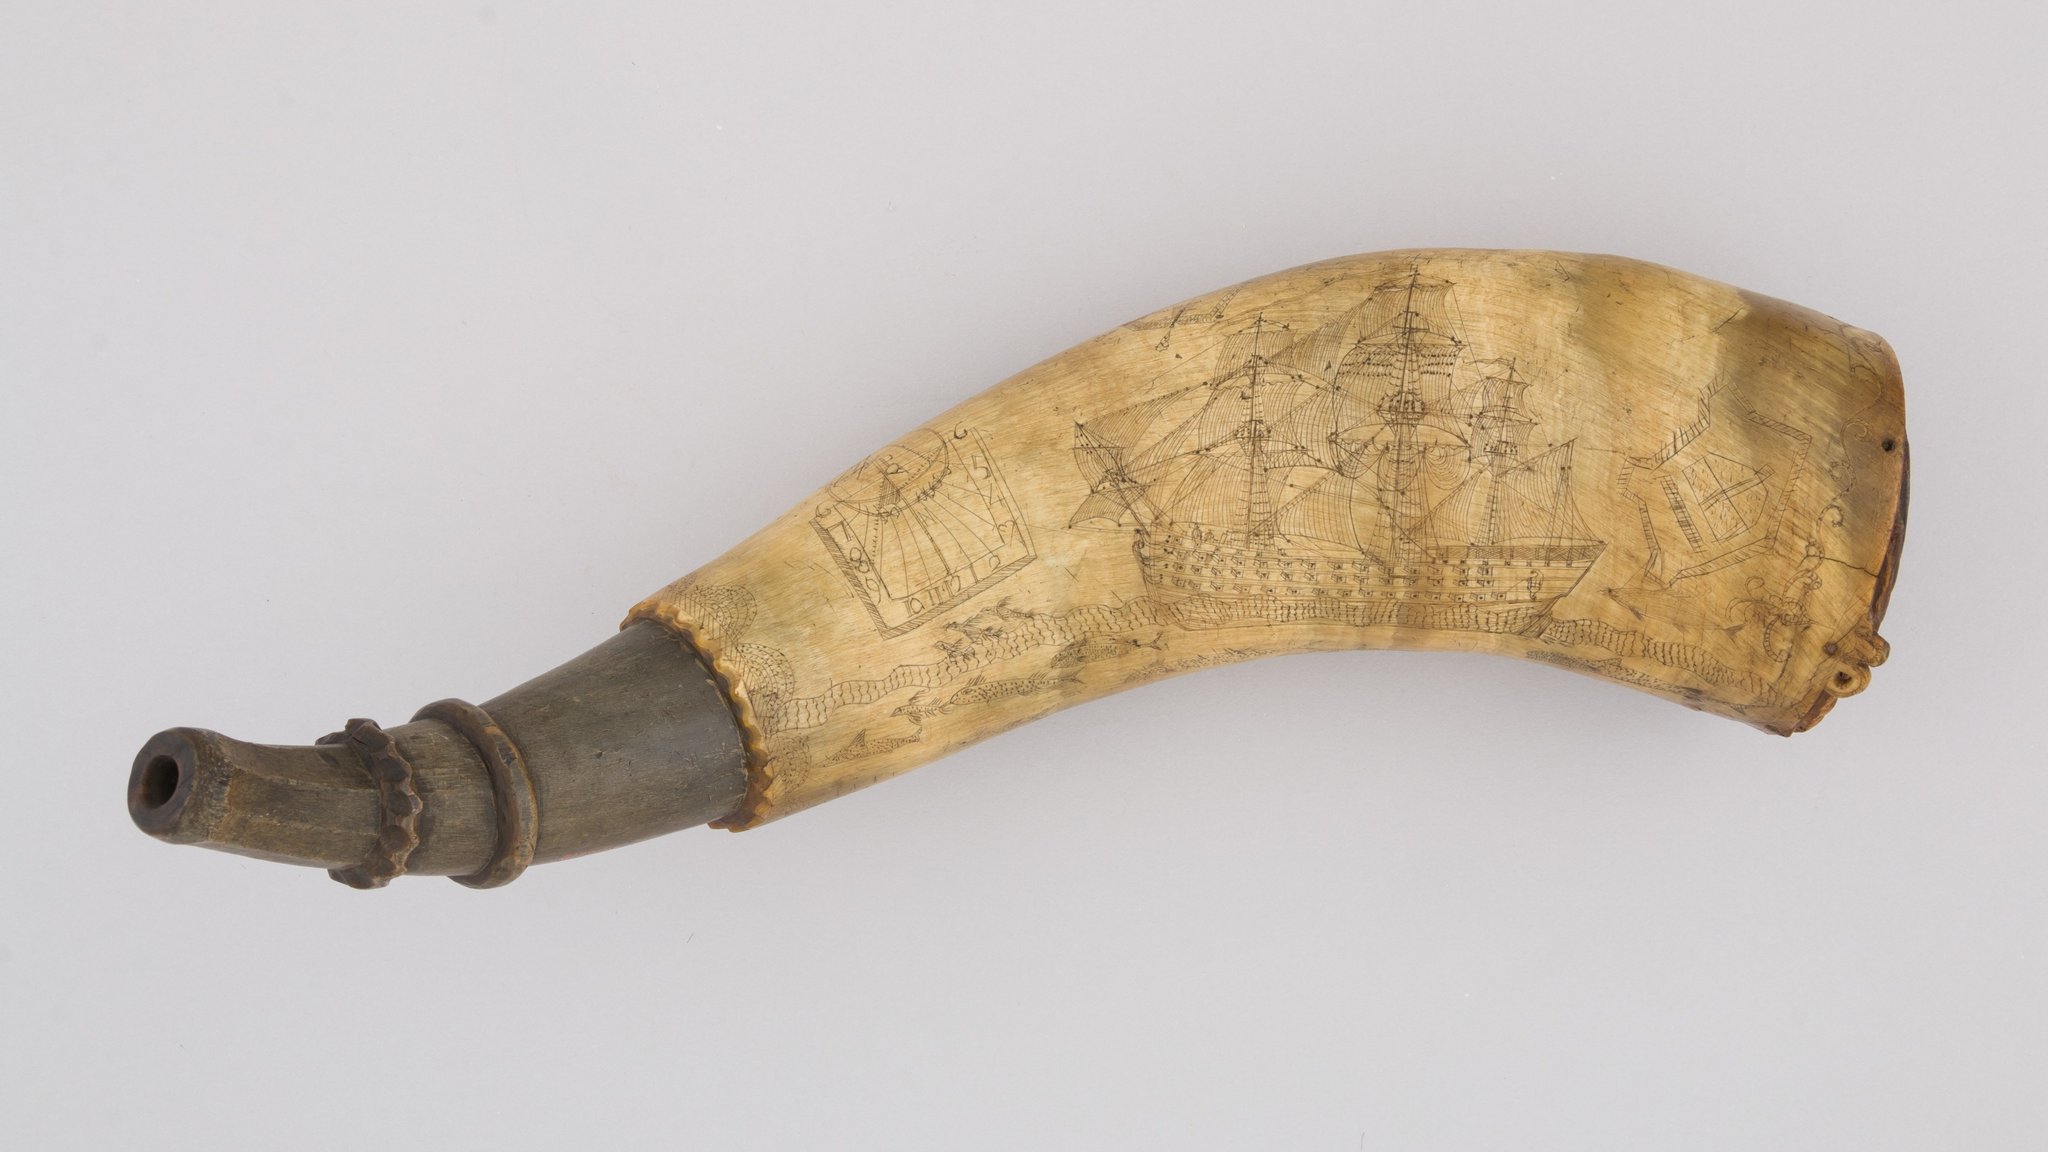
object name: powder horn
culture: colonial american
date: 1775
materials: horn, wood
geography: united states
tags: fish,ships